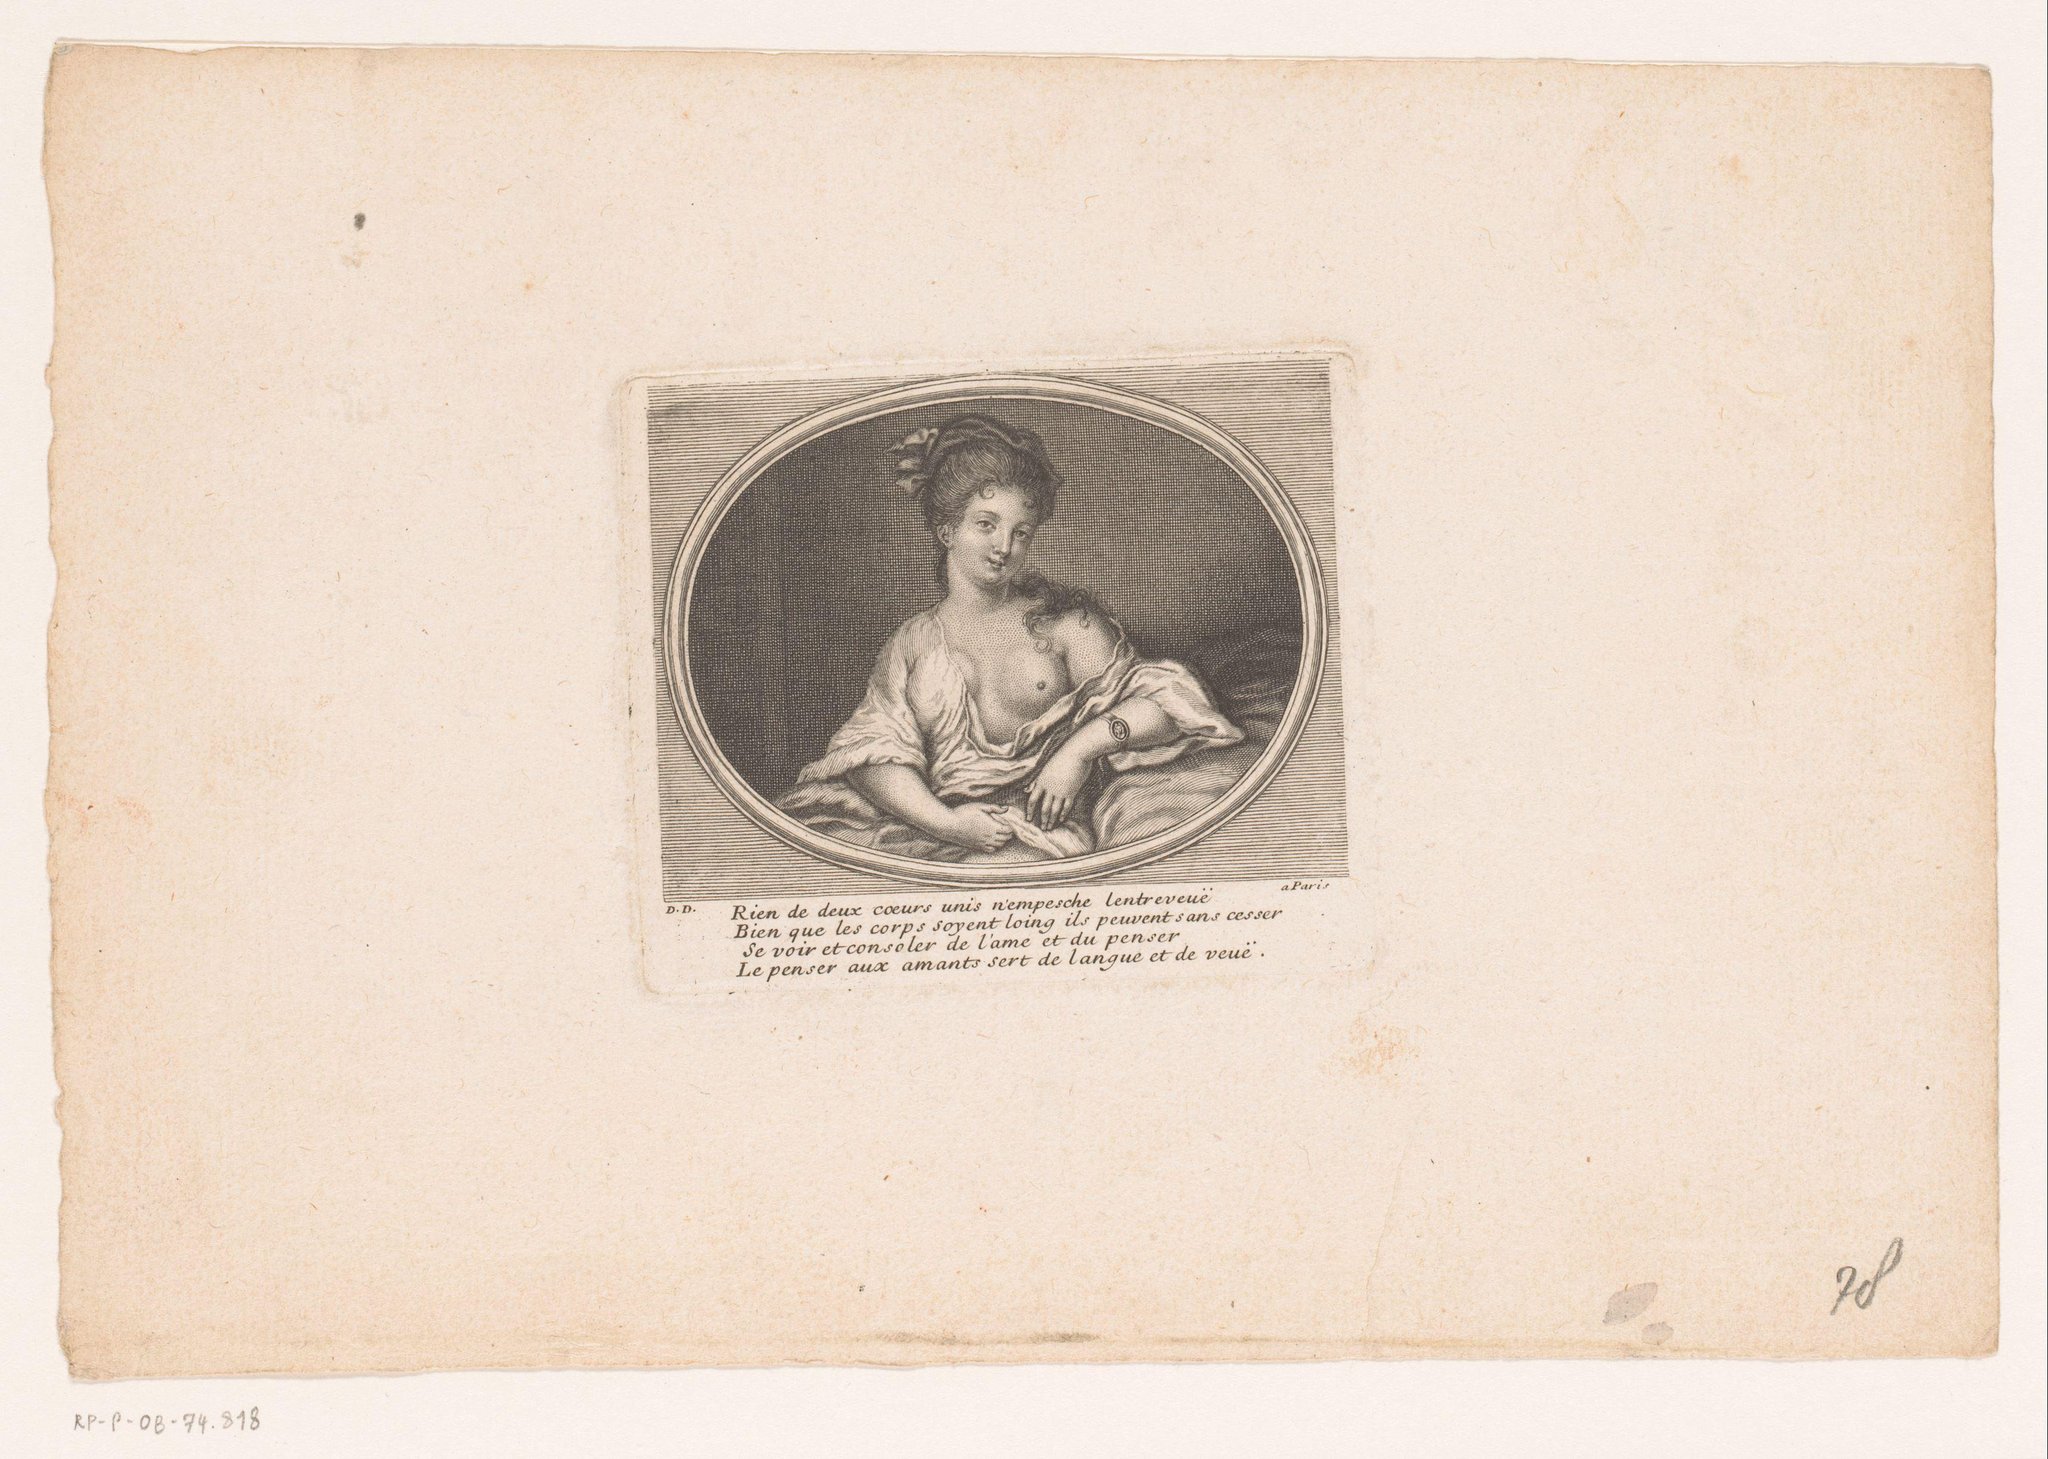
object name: print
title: Vrouw met een ontblote borst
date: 1740-1800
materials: paper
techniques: engraving, etching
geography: france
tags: woman (showing herself) undressed, quasi-nude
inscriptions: collector's mark: Lugt 2228